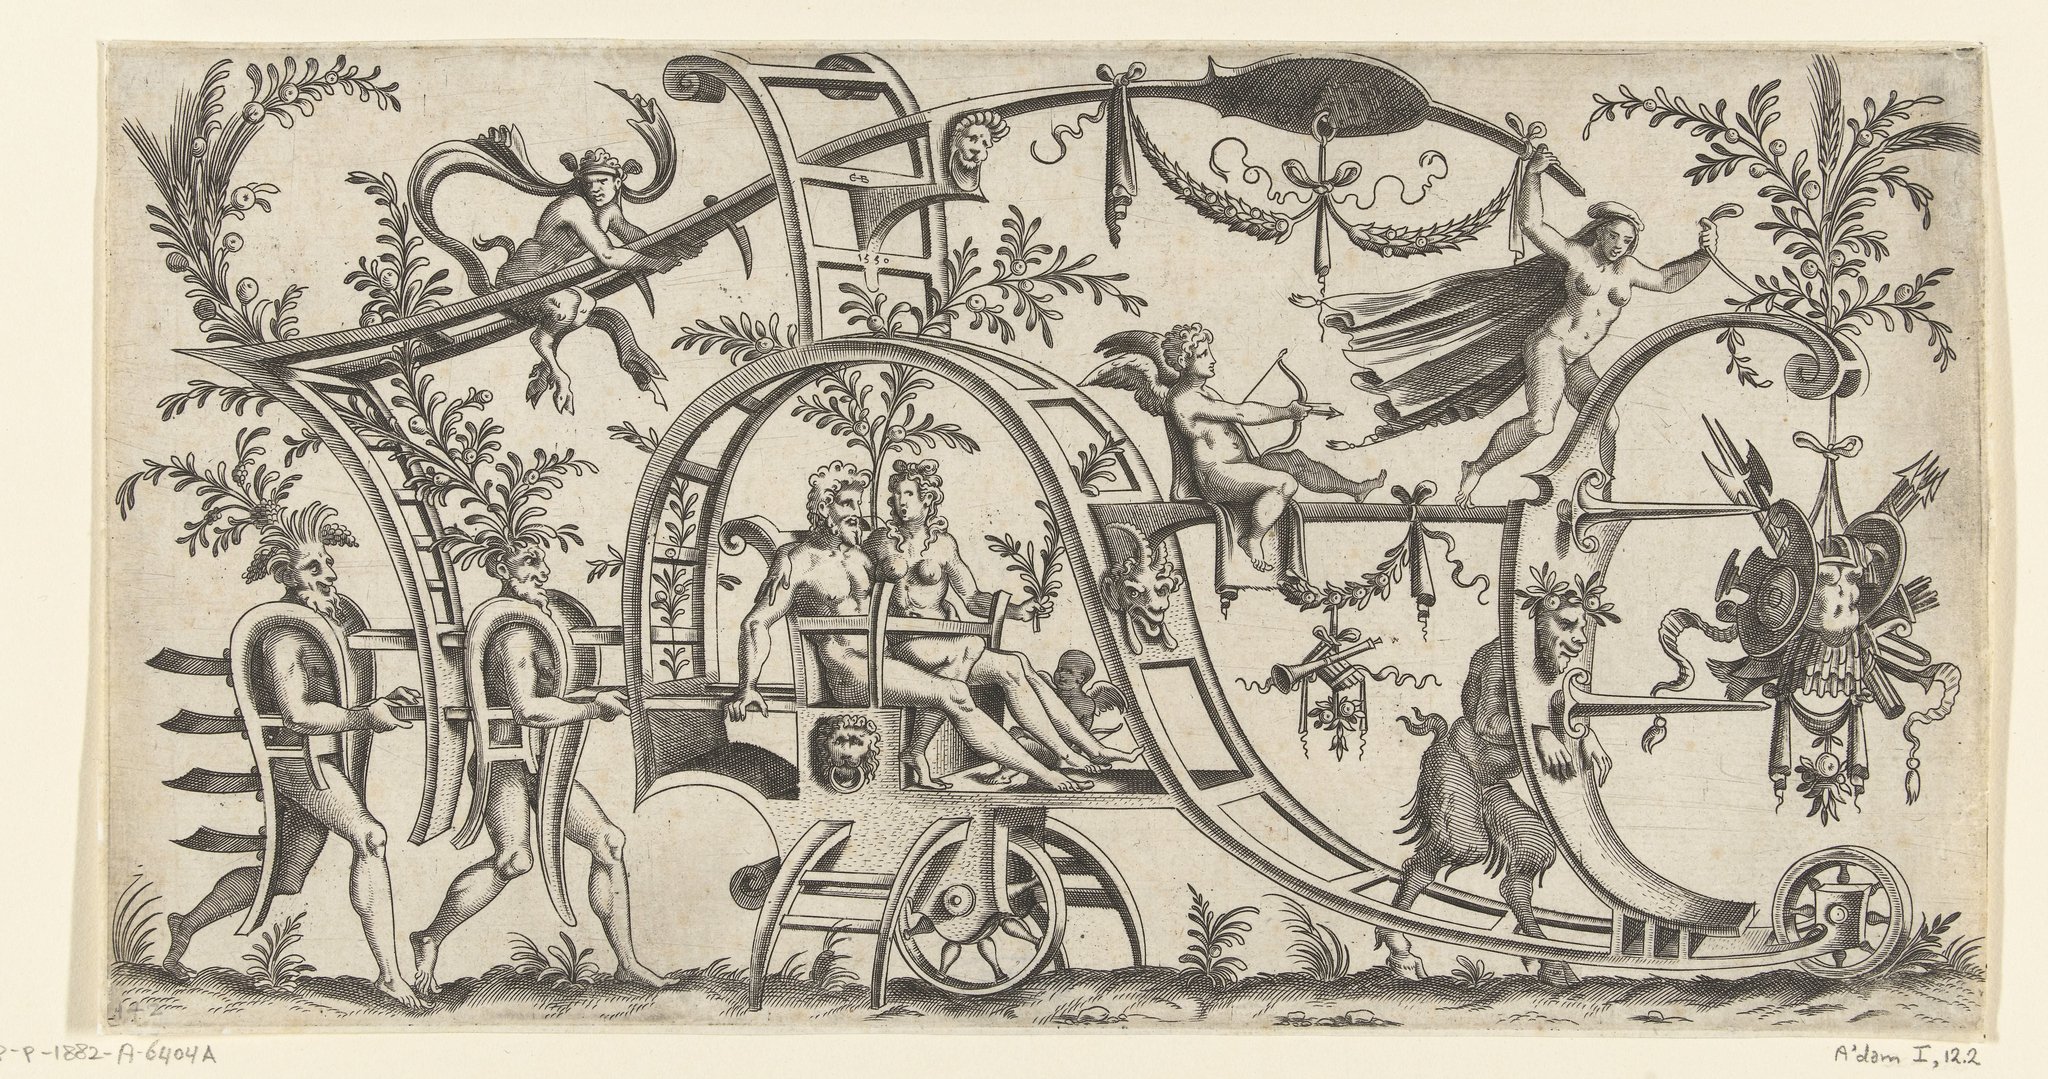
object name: ornament print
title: Triomfwagens van grotesken en van rolwerk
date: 1550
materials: paper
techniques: engraving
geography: netherlands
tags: (other) ornaments derived from objects (with name), satyr(s) (in general)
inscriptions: date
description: De wagen wordt getrokken door een sater en geduwd door twee andere, allen gevangen in het frame. Blad uit serie van 8 bladen met triomfwagens van grotesken en van rolwerk met saters, dieren en diverse andere wezens, gedecoreerd met trofeeëen, guirlandes en bladranken.